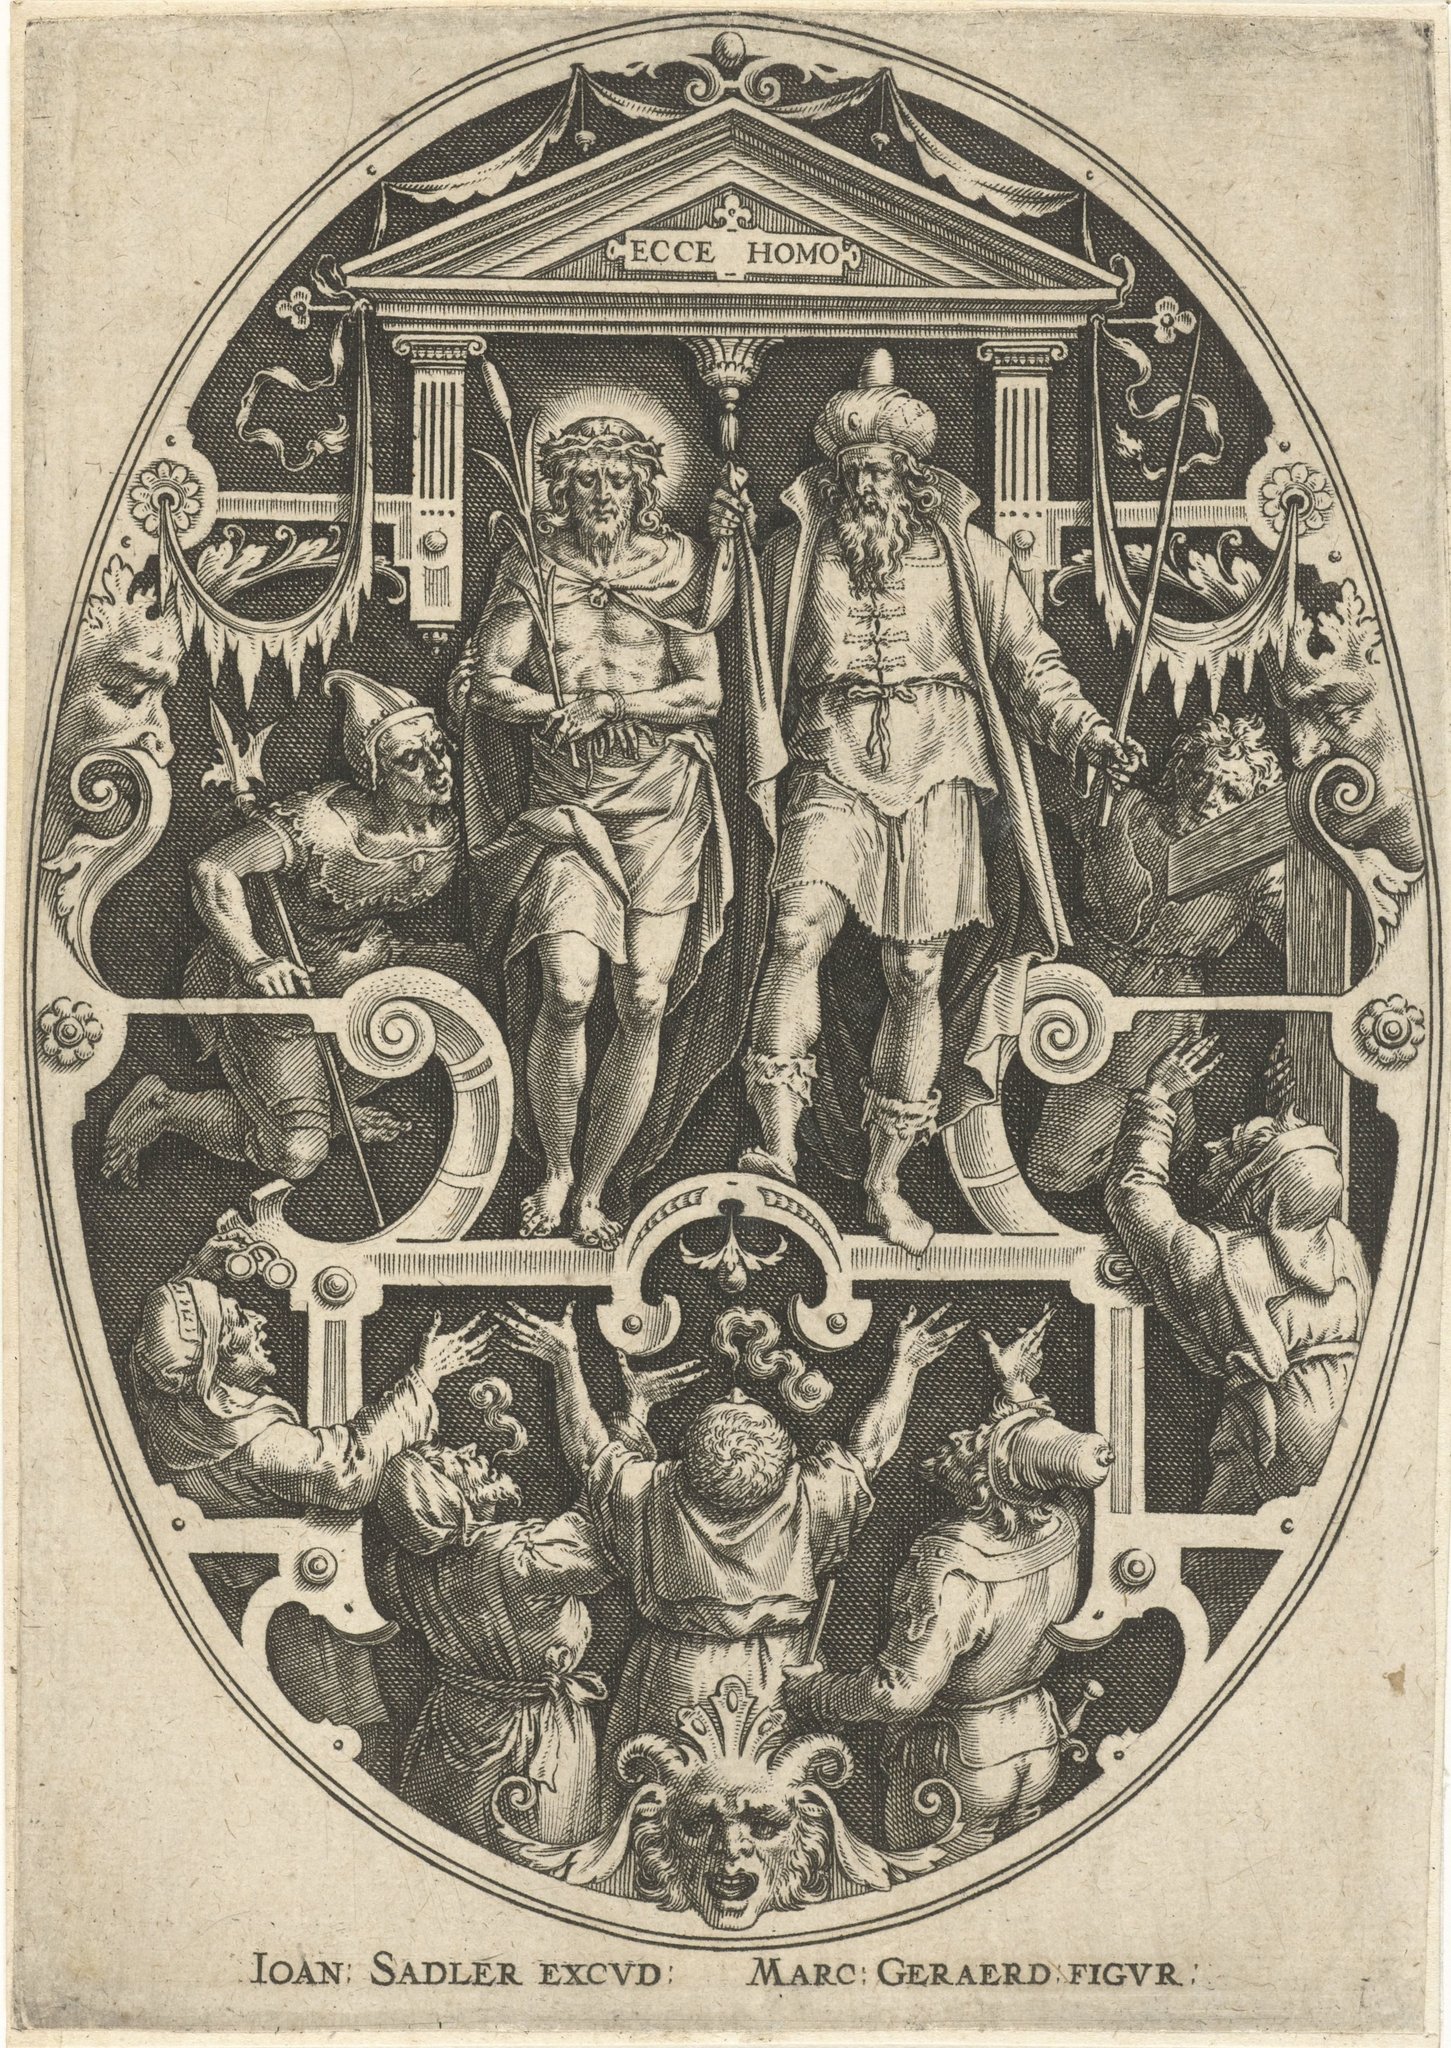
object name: ornament print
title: Ecce Homo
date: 1560-1600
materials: paper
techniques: engraving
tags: ornaments ~ art, pilate showing christ to the people, 'ostentatio christi', 'ecce homo' (john 19:4-6)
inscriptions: collector's mark: Lugt 2228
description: Pontius Pilatus toont de gegeselde Christus aan het Joodse volk, die hem uitjouwt. In staand ovaal met ornament. De zevende prent van een dertiendelige serie ornamentprenten over de passie van Christus.